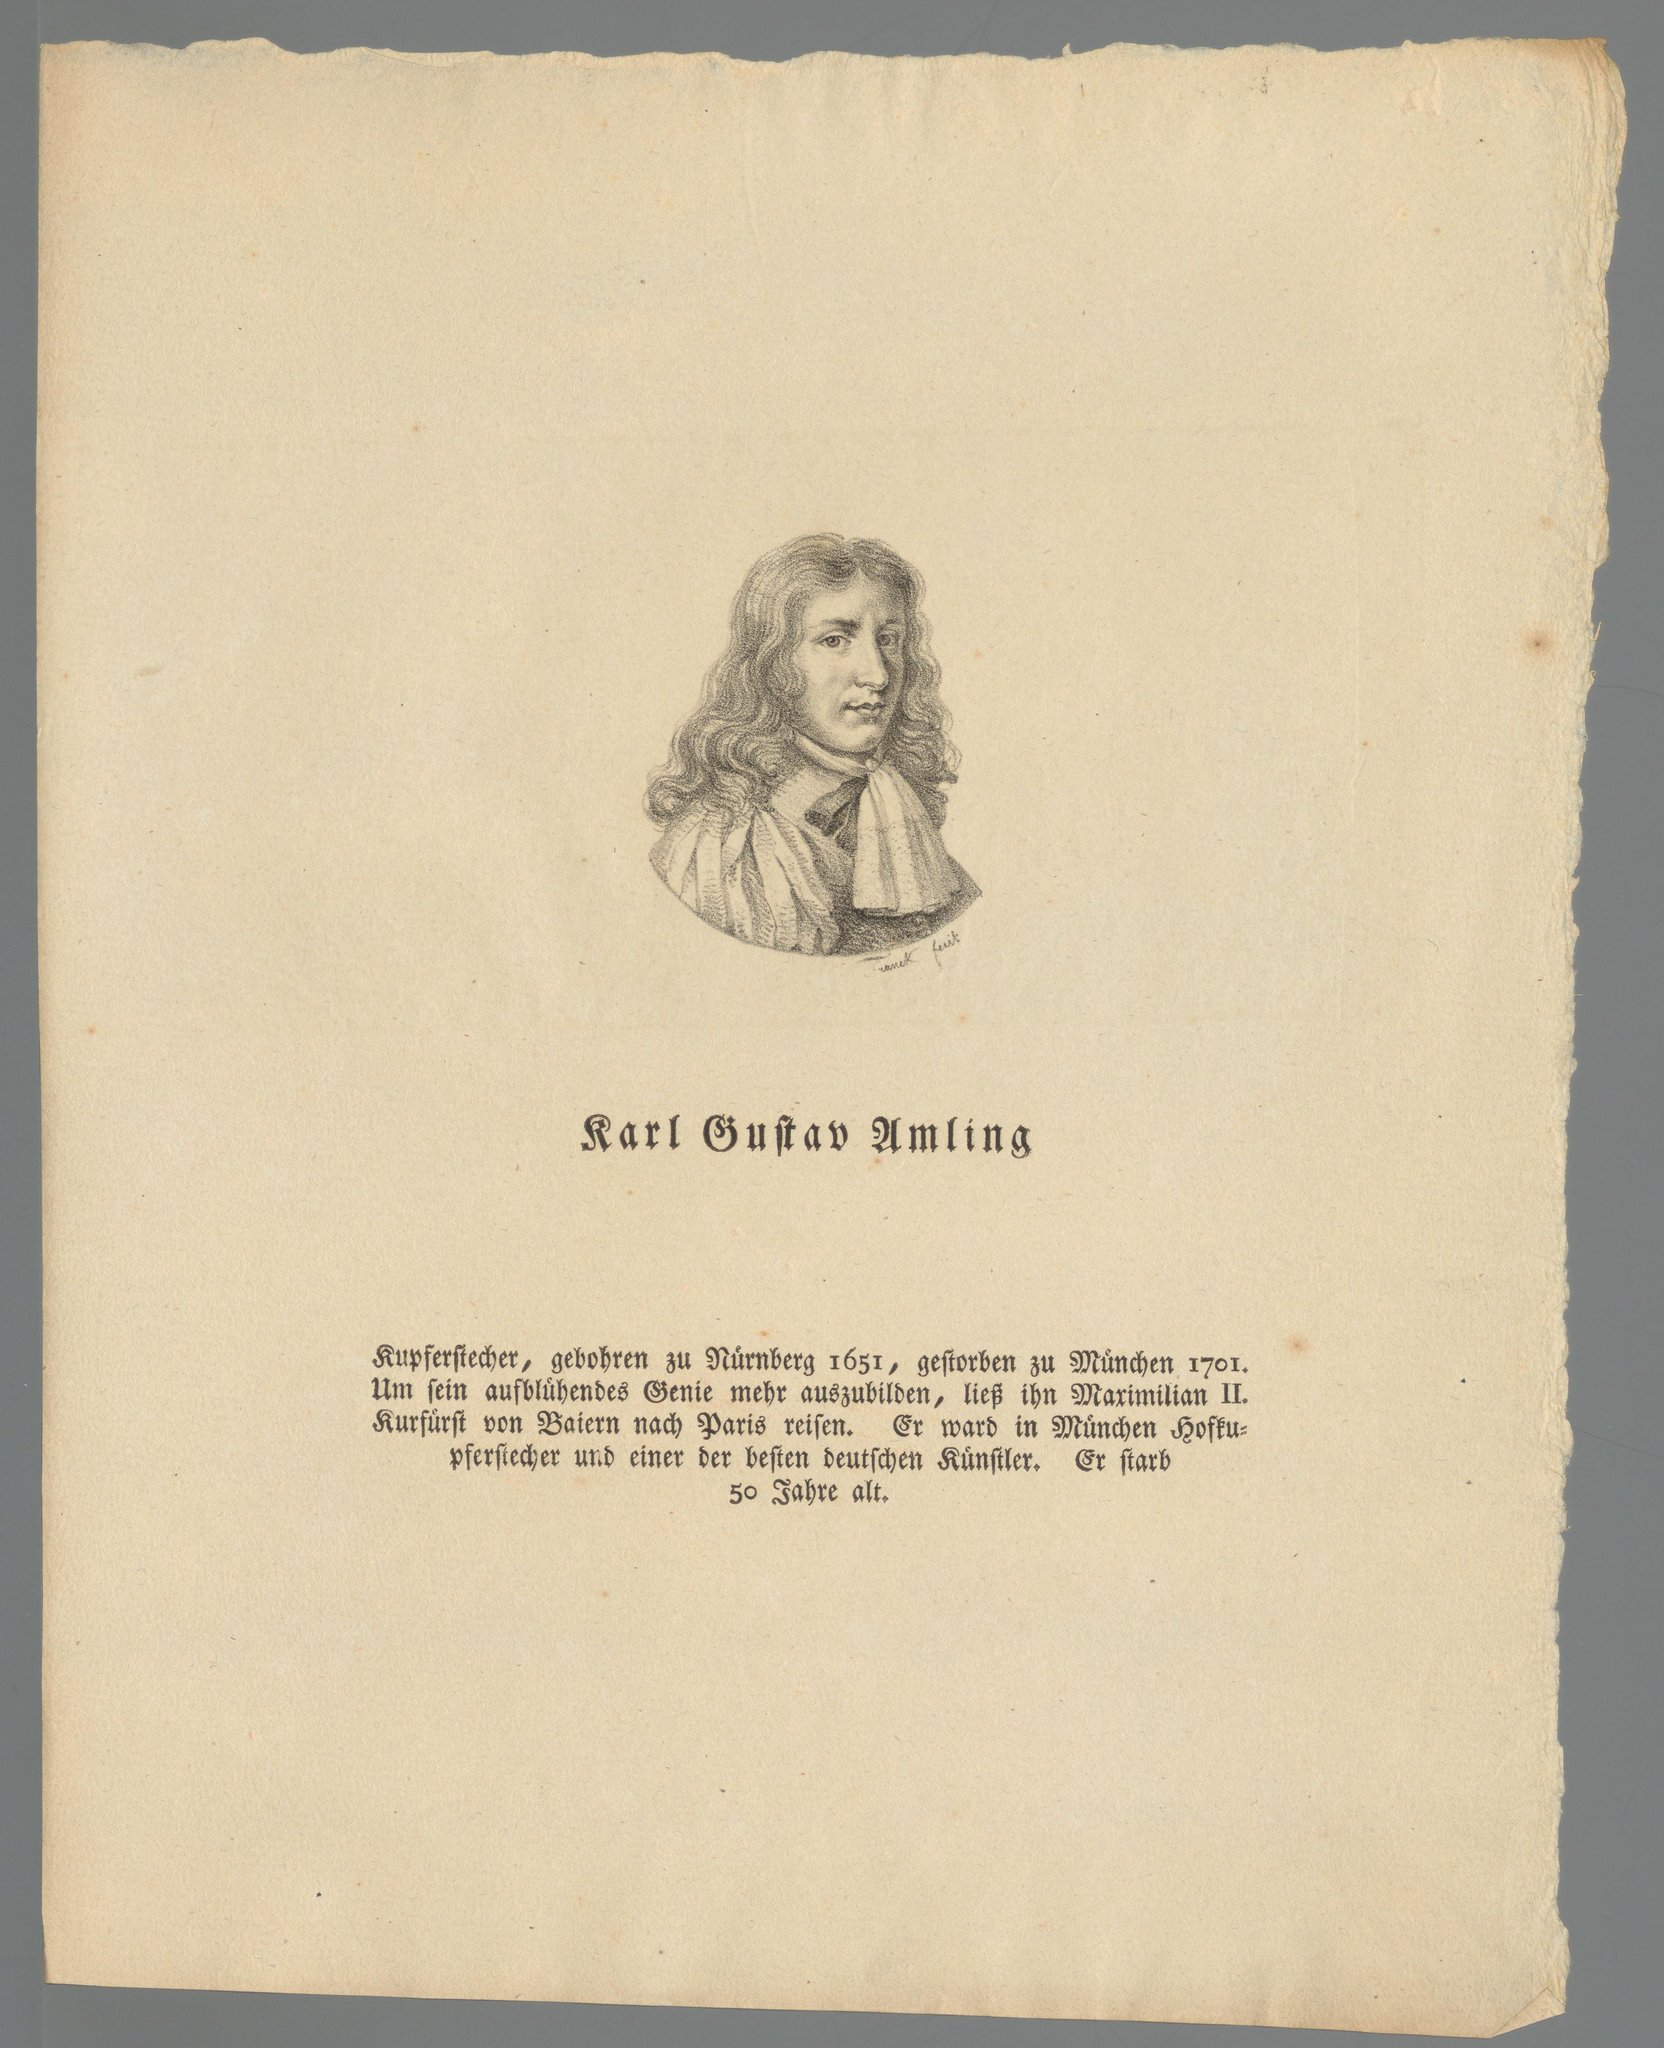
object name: print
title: Karl Gustav Amling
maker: maximilian franck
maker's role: print maker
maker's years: 1780-1830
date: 1813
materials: paper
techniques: letterpress printing, lithograph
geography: munich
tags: print maker, karl gustav amling, historical persons, portrait, self-portrait of painter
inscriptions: collector's mark: Lugt 2228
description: Prent uit: Lindauer, Joseph. Deutsche Künstler-Gallerie. München: Maximilian Franck, 1813.